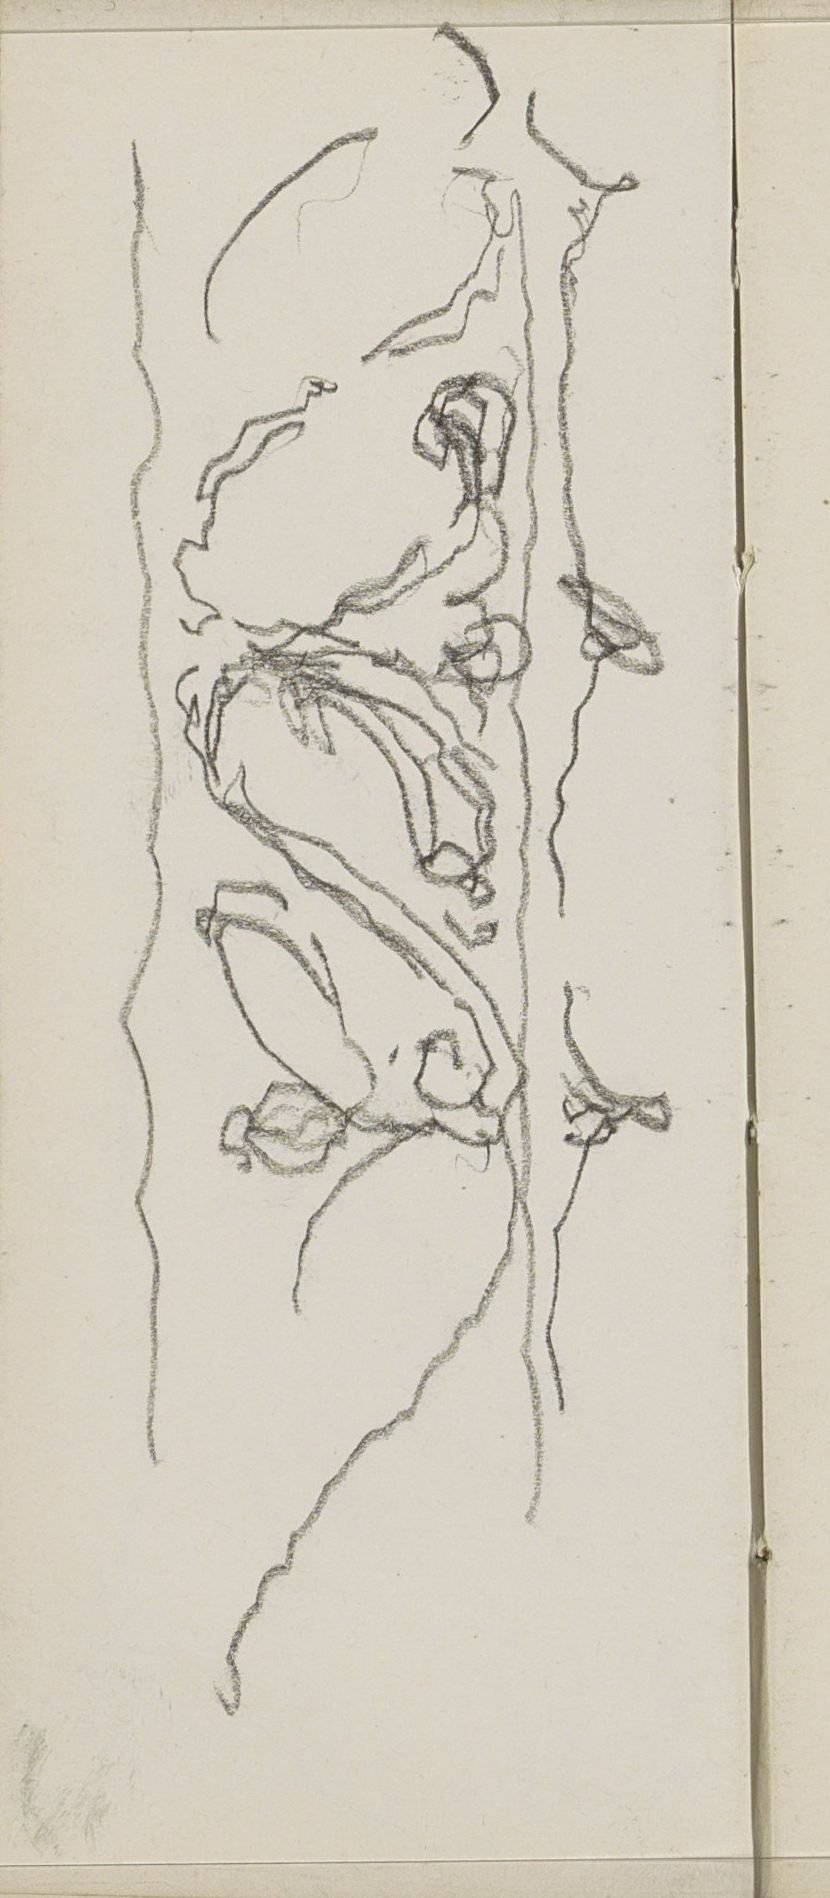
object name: sketchbook leaf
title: Band met floraal motief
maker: gerrit willem dijsselhof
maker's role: designer, draughtsman, print maker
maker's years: 1866-1924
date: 1876-1924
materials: chalk, paper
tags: flowers ~ ornament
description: Blad 14 verso uit een schetsboek met 40 bladen.